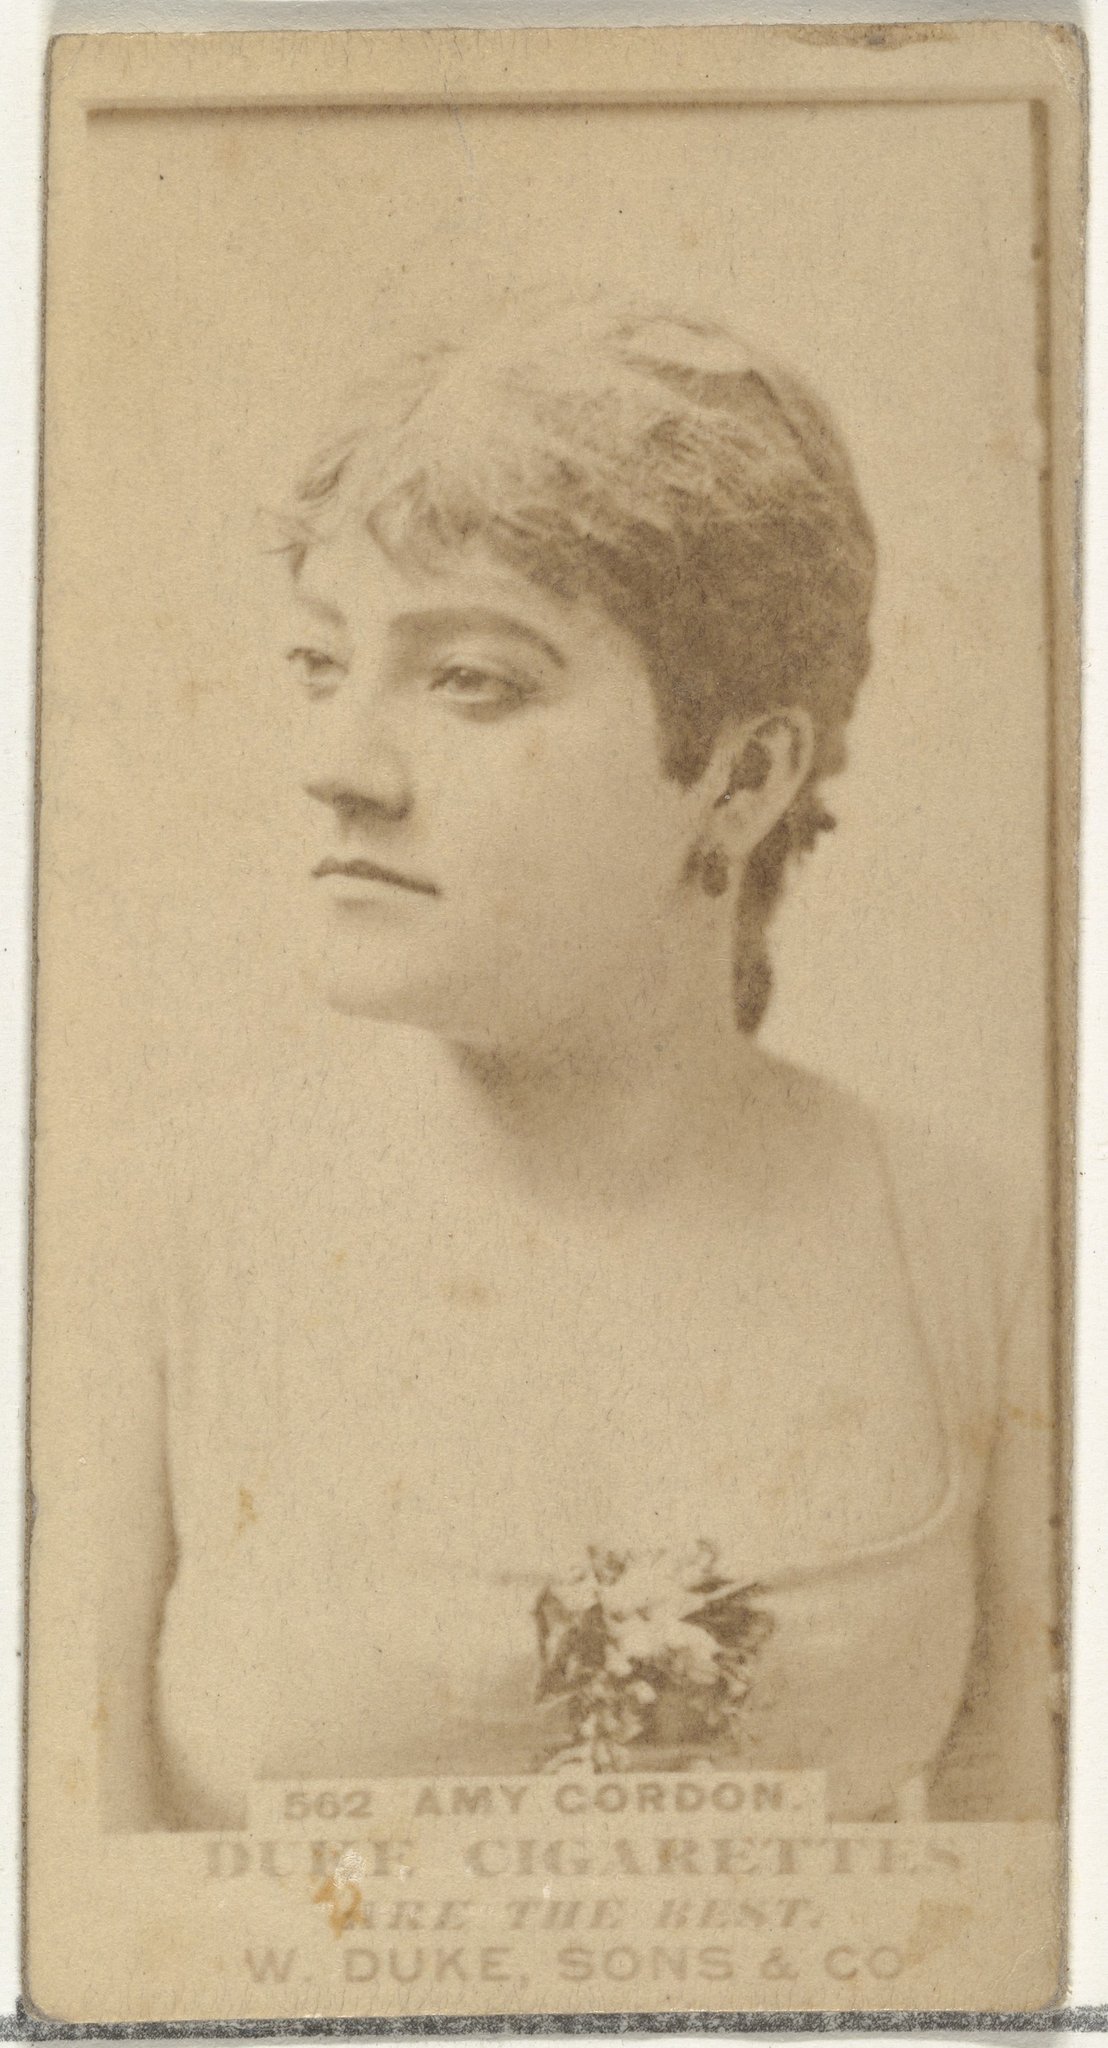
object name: photograph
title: Card Number 562, Amy Gordon, from the Actors and Actresses series (N145-7) issued by Duke Sons & Co. to promote Duke Cigarettes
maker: w. duke, sons & co.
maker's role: publisher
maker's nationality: american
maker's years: 1870-1920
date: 1880-1889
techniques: albumen silver print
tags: portraits,women,actresses